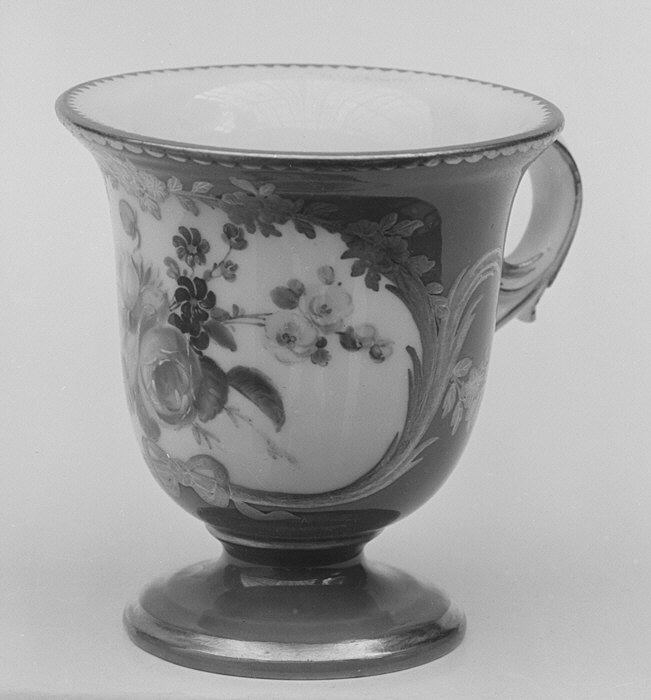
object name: ice cream cup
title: Ice cream cup (tasse à glace) (one of thirty-one) (part of a service)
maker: sèvres manufactory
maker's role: manufactory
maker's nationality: french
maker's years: 1740-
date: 1771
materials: soft paste porcelain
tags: flowers